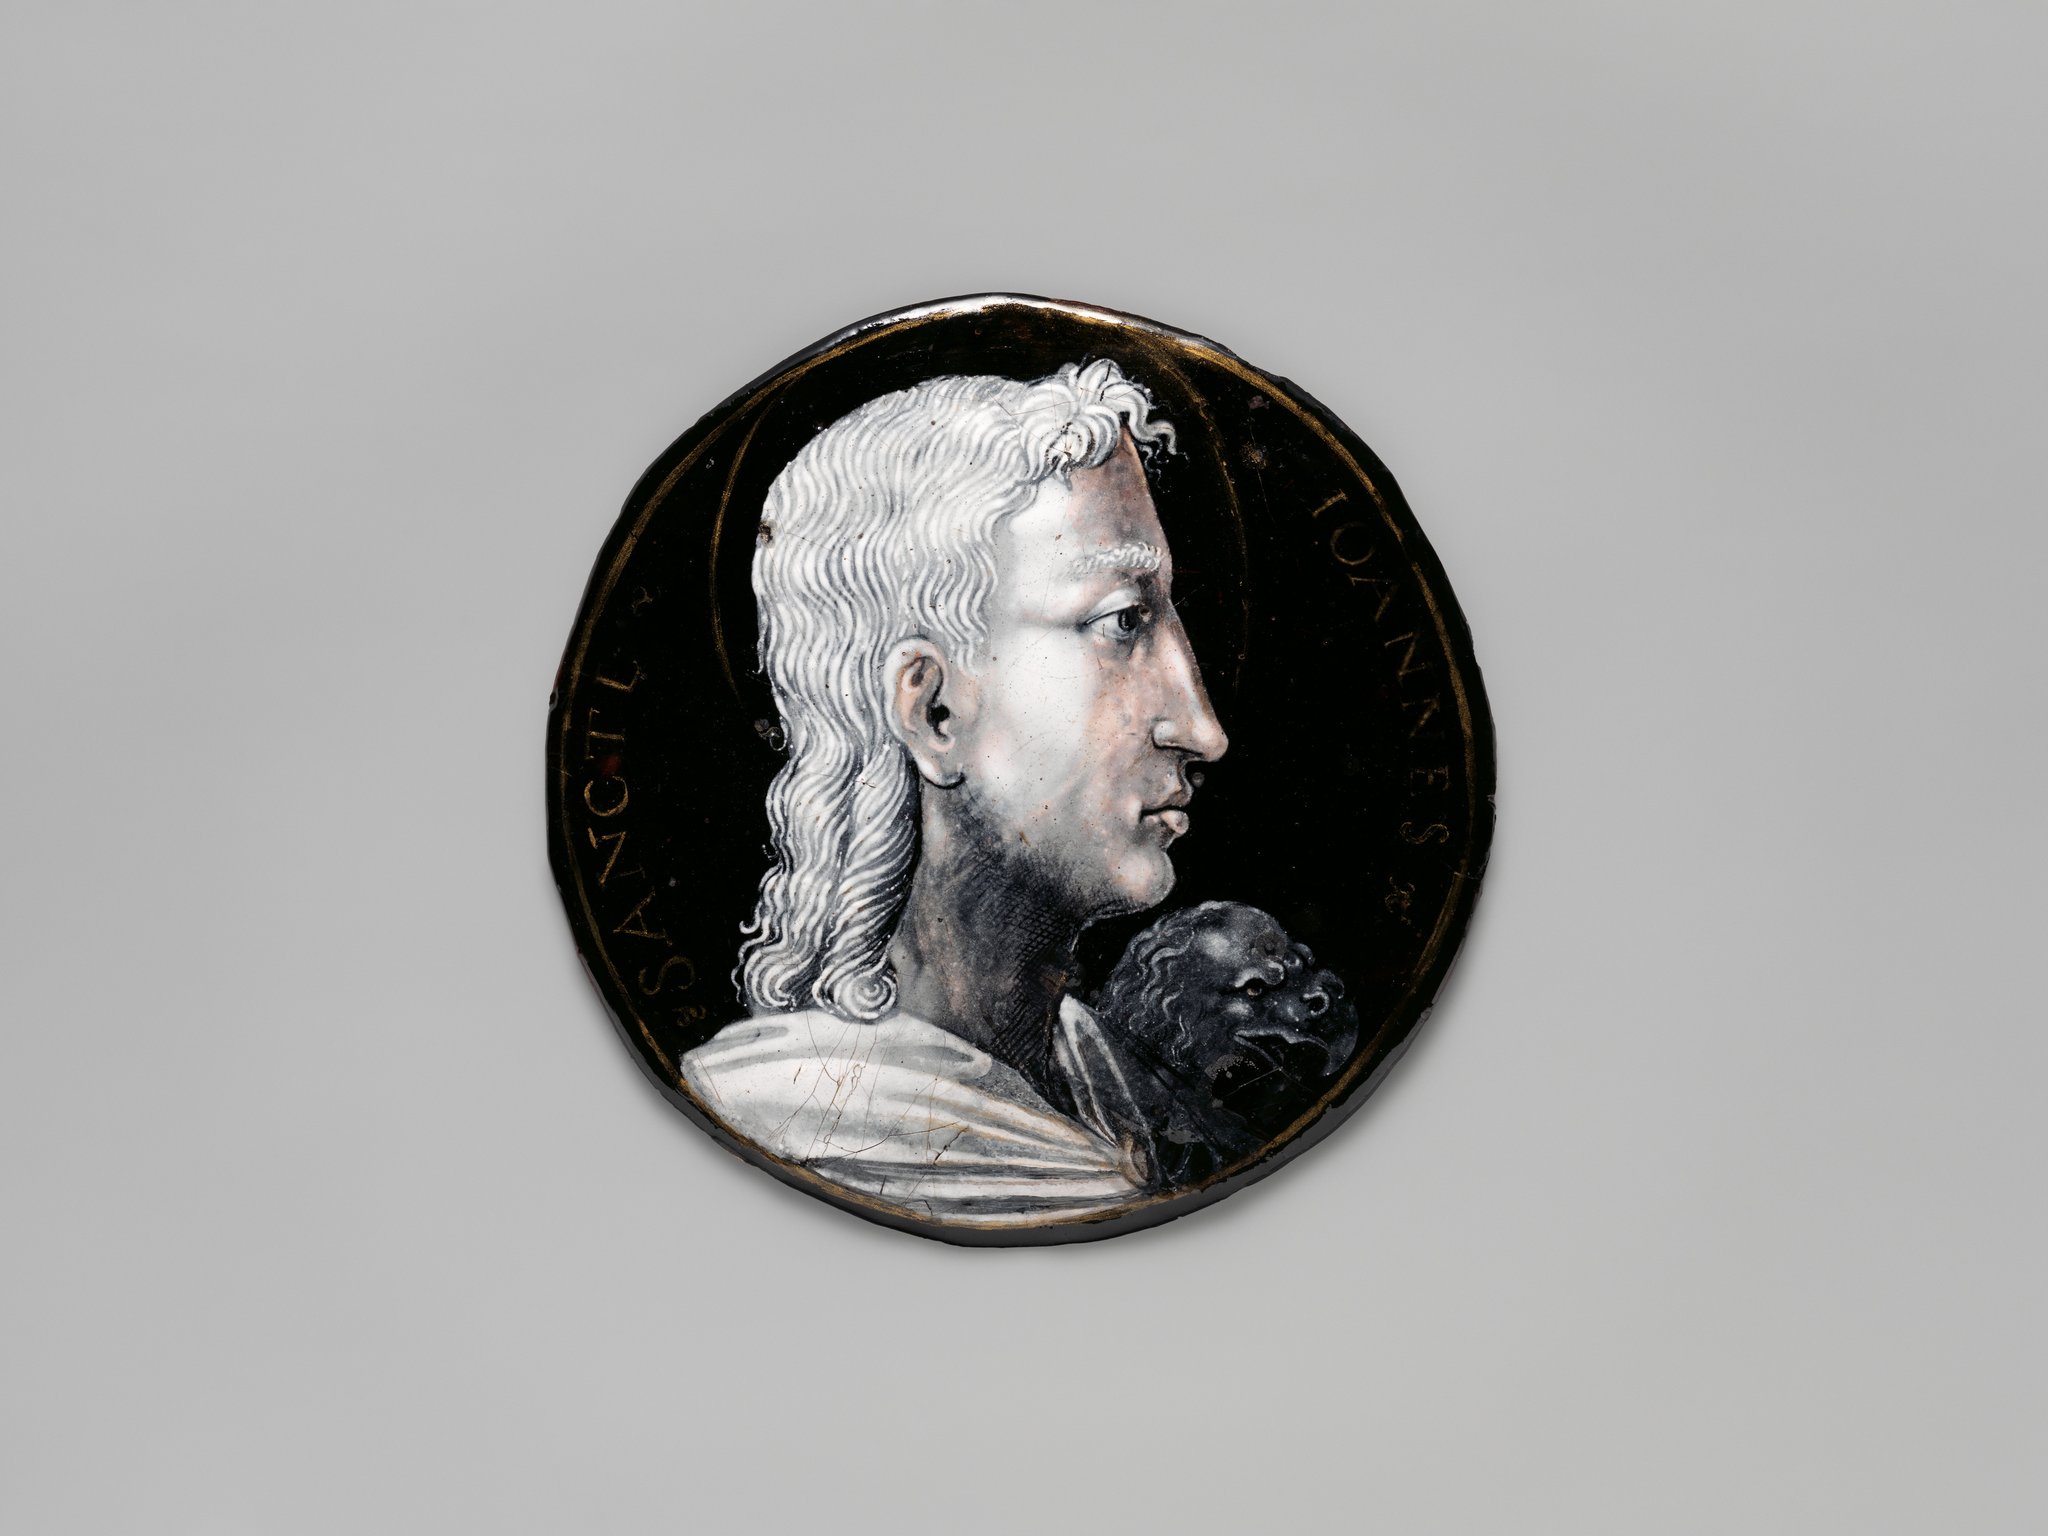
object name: roundel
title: Saint John the Evangelist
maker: jean iii pénicaud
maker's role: enameler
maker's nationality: french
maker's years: 1470-1570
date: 1550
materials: copper, enamel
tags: profiles,saint john the evangelist